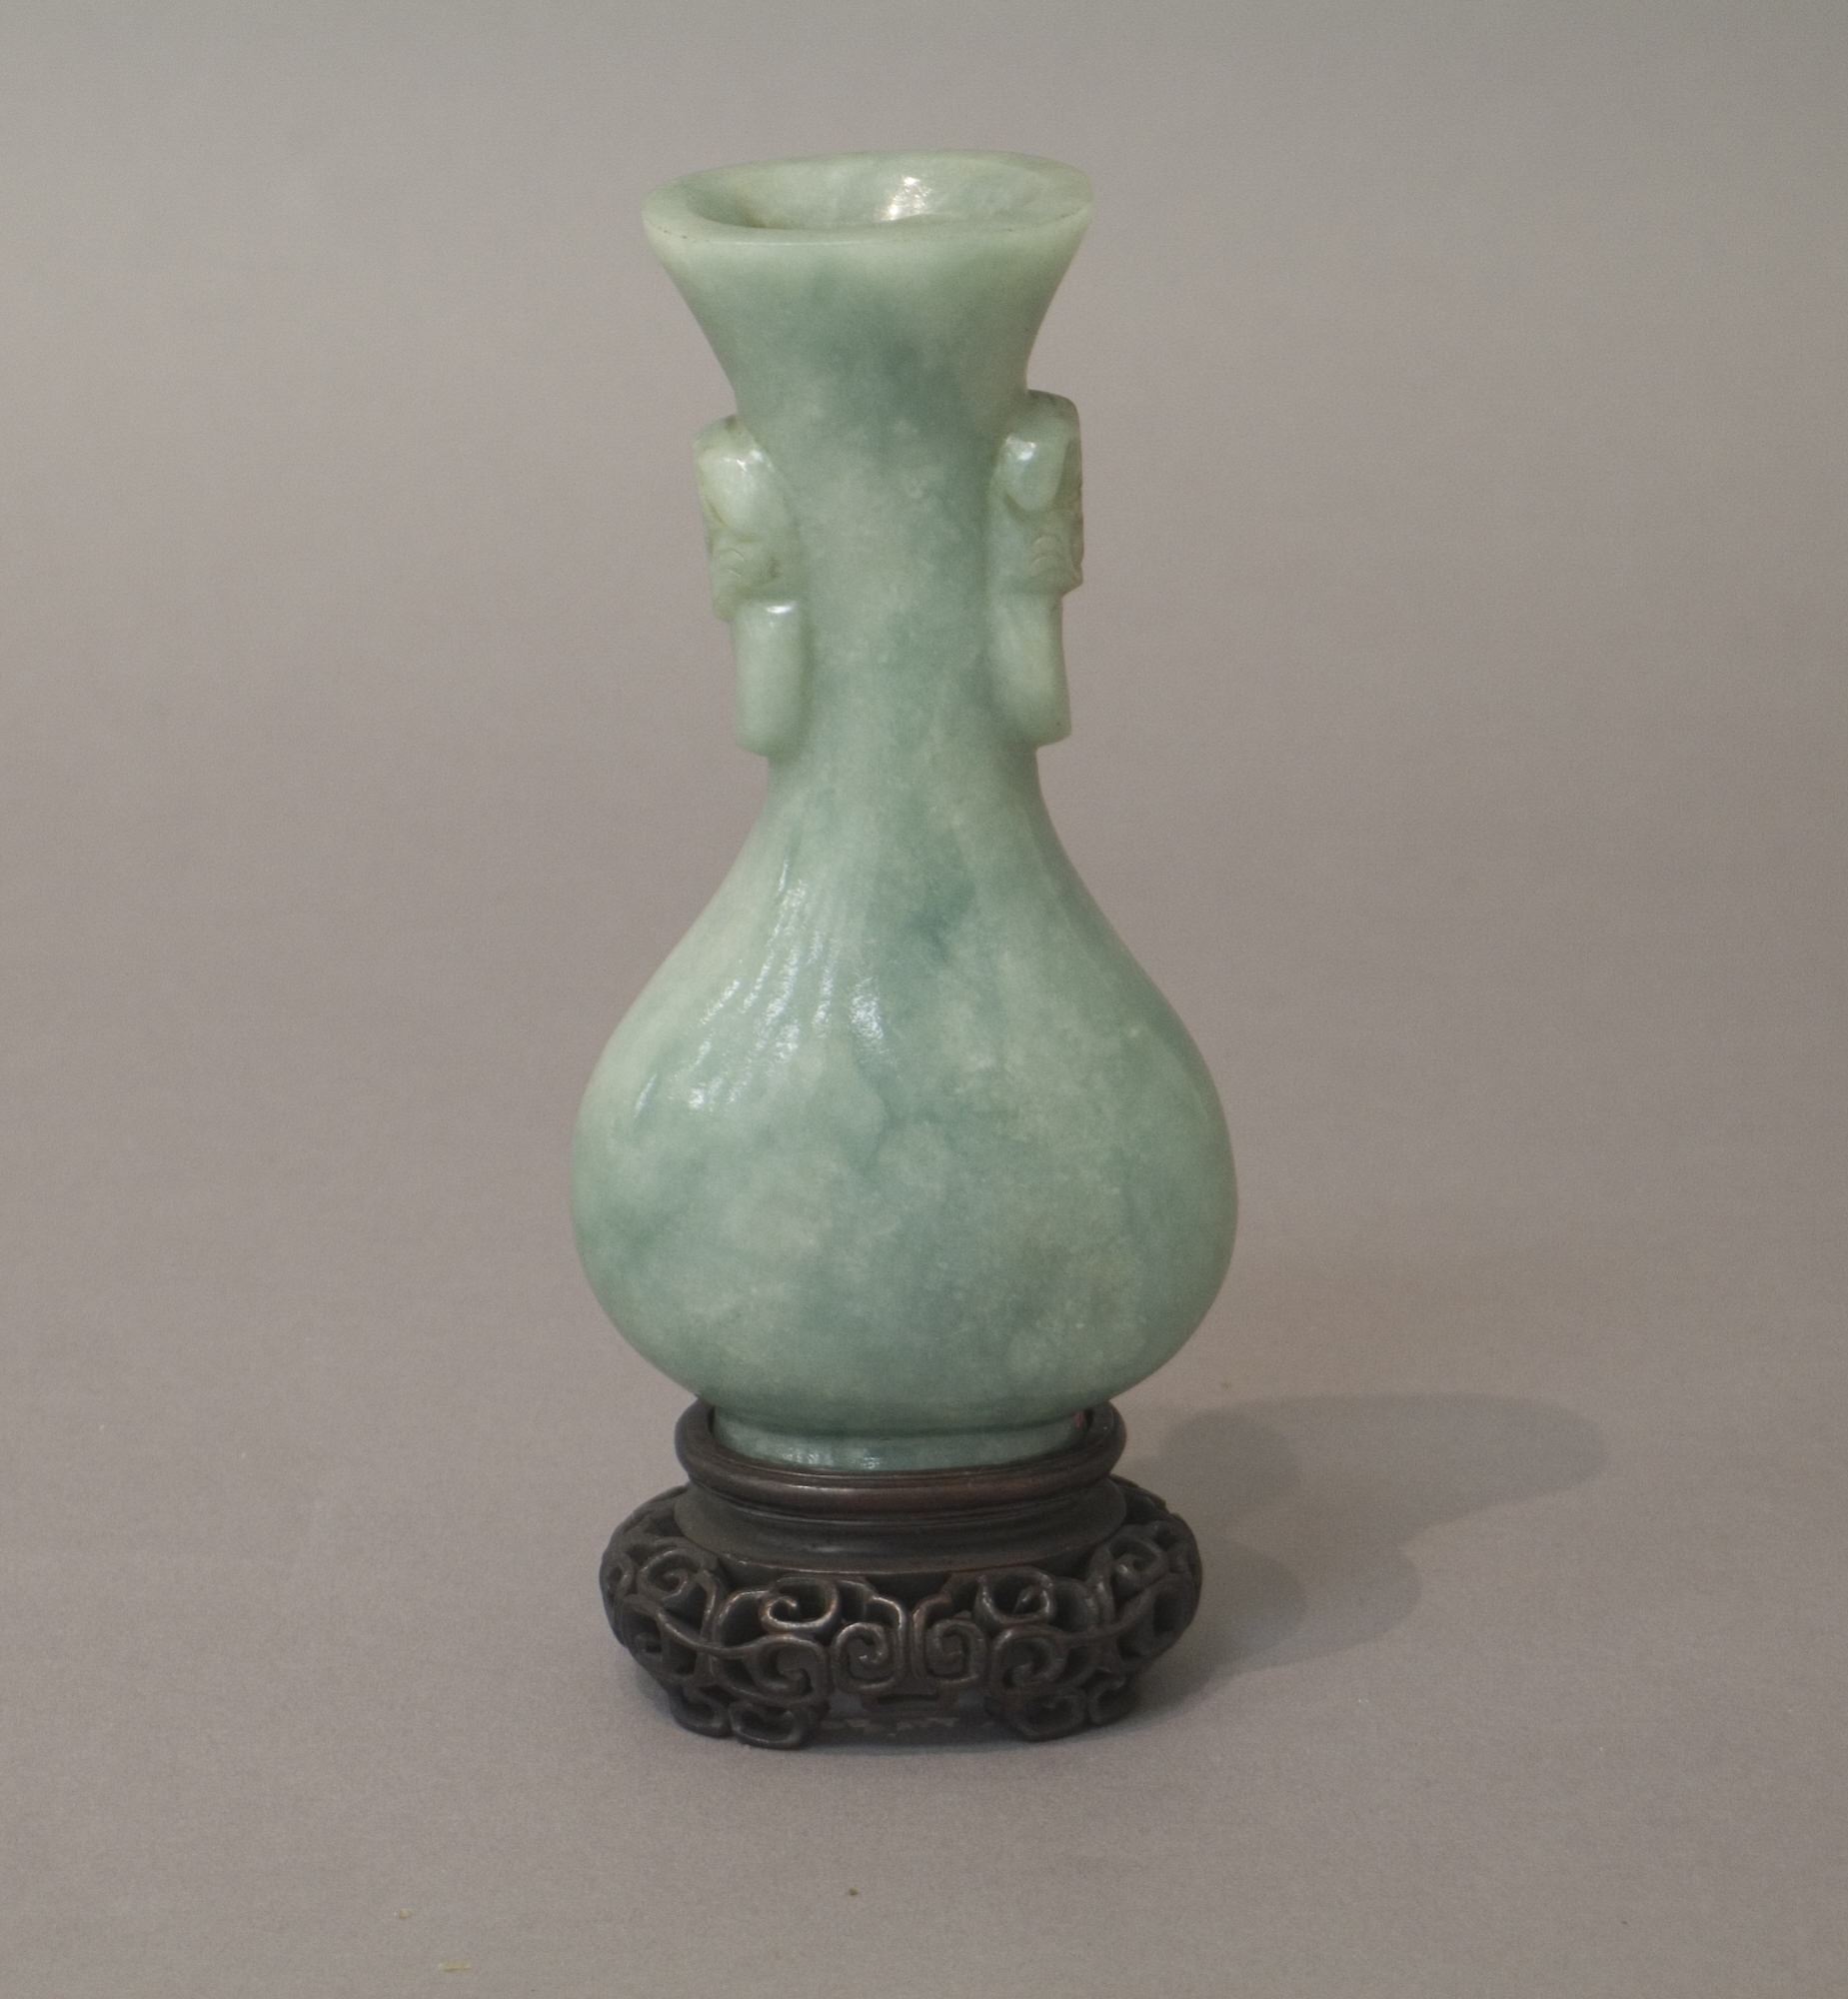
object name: vase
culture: chinese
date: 1736-1795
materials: jade